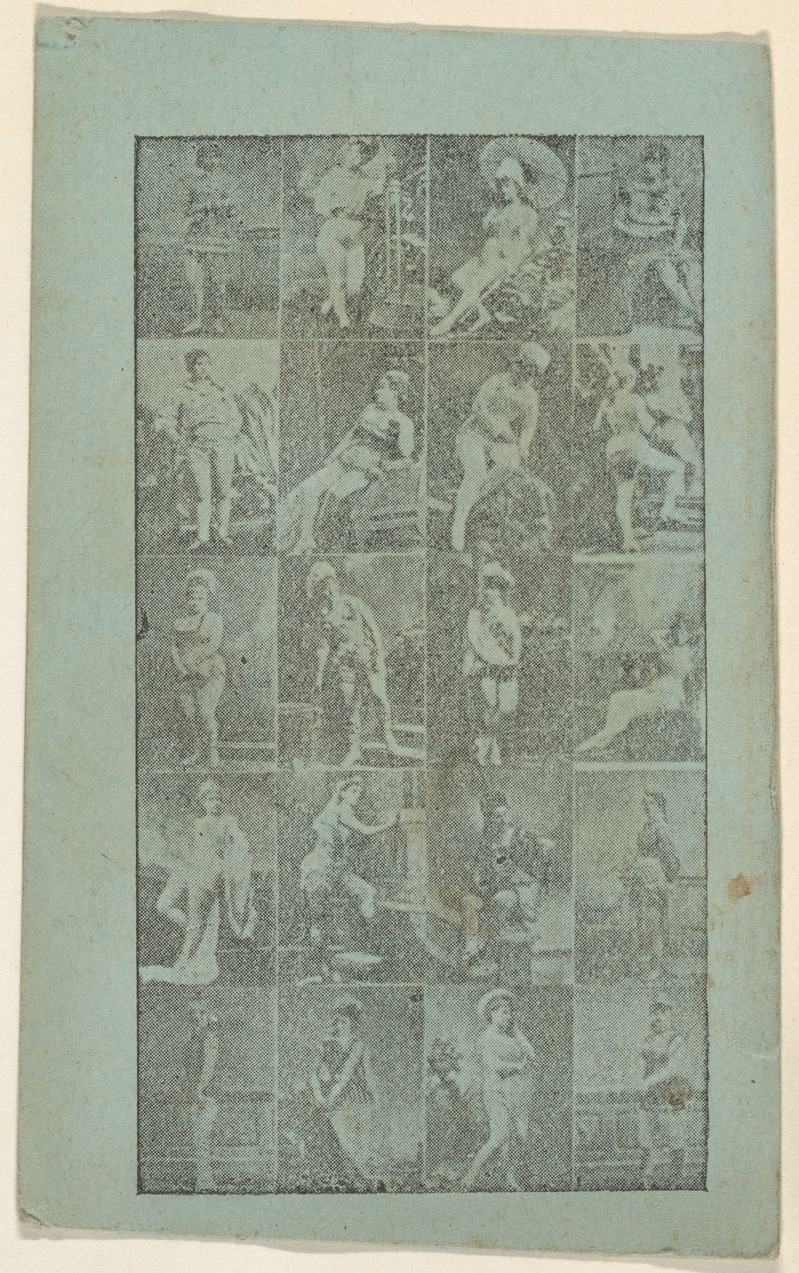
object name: photograph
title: Grid of twenty portraits of actresses (blue), from the Actresses series (N668)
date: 1888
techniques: albumen silver print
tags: portraits,women,actresses